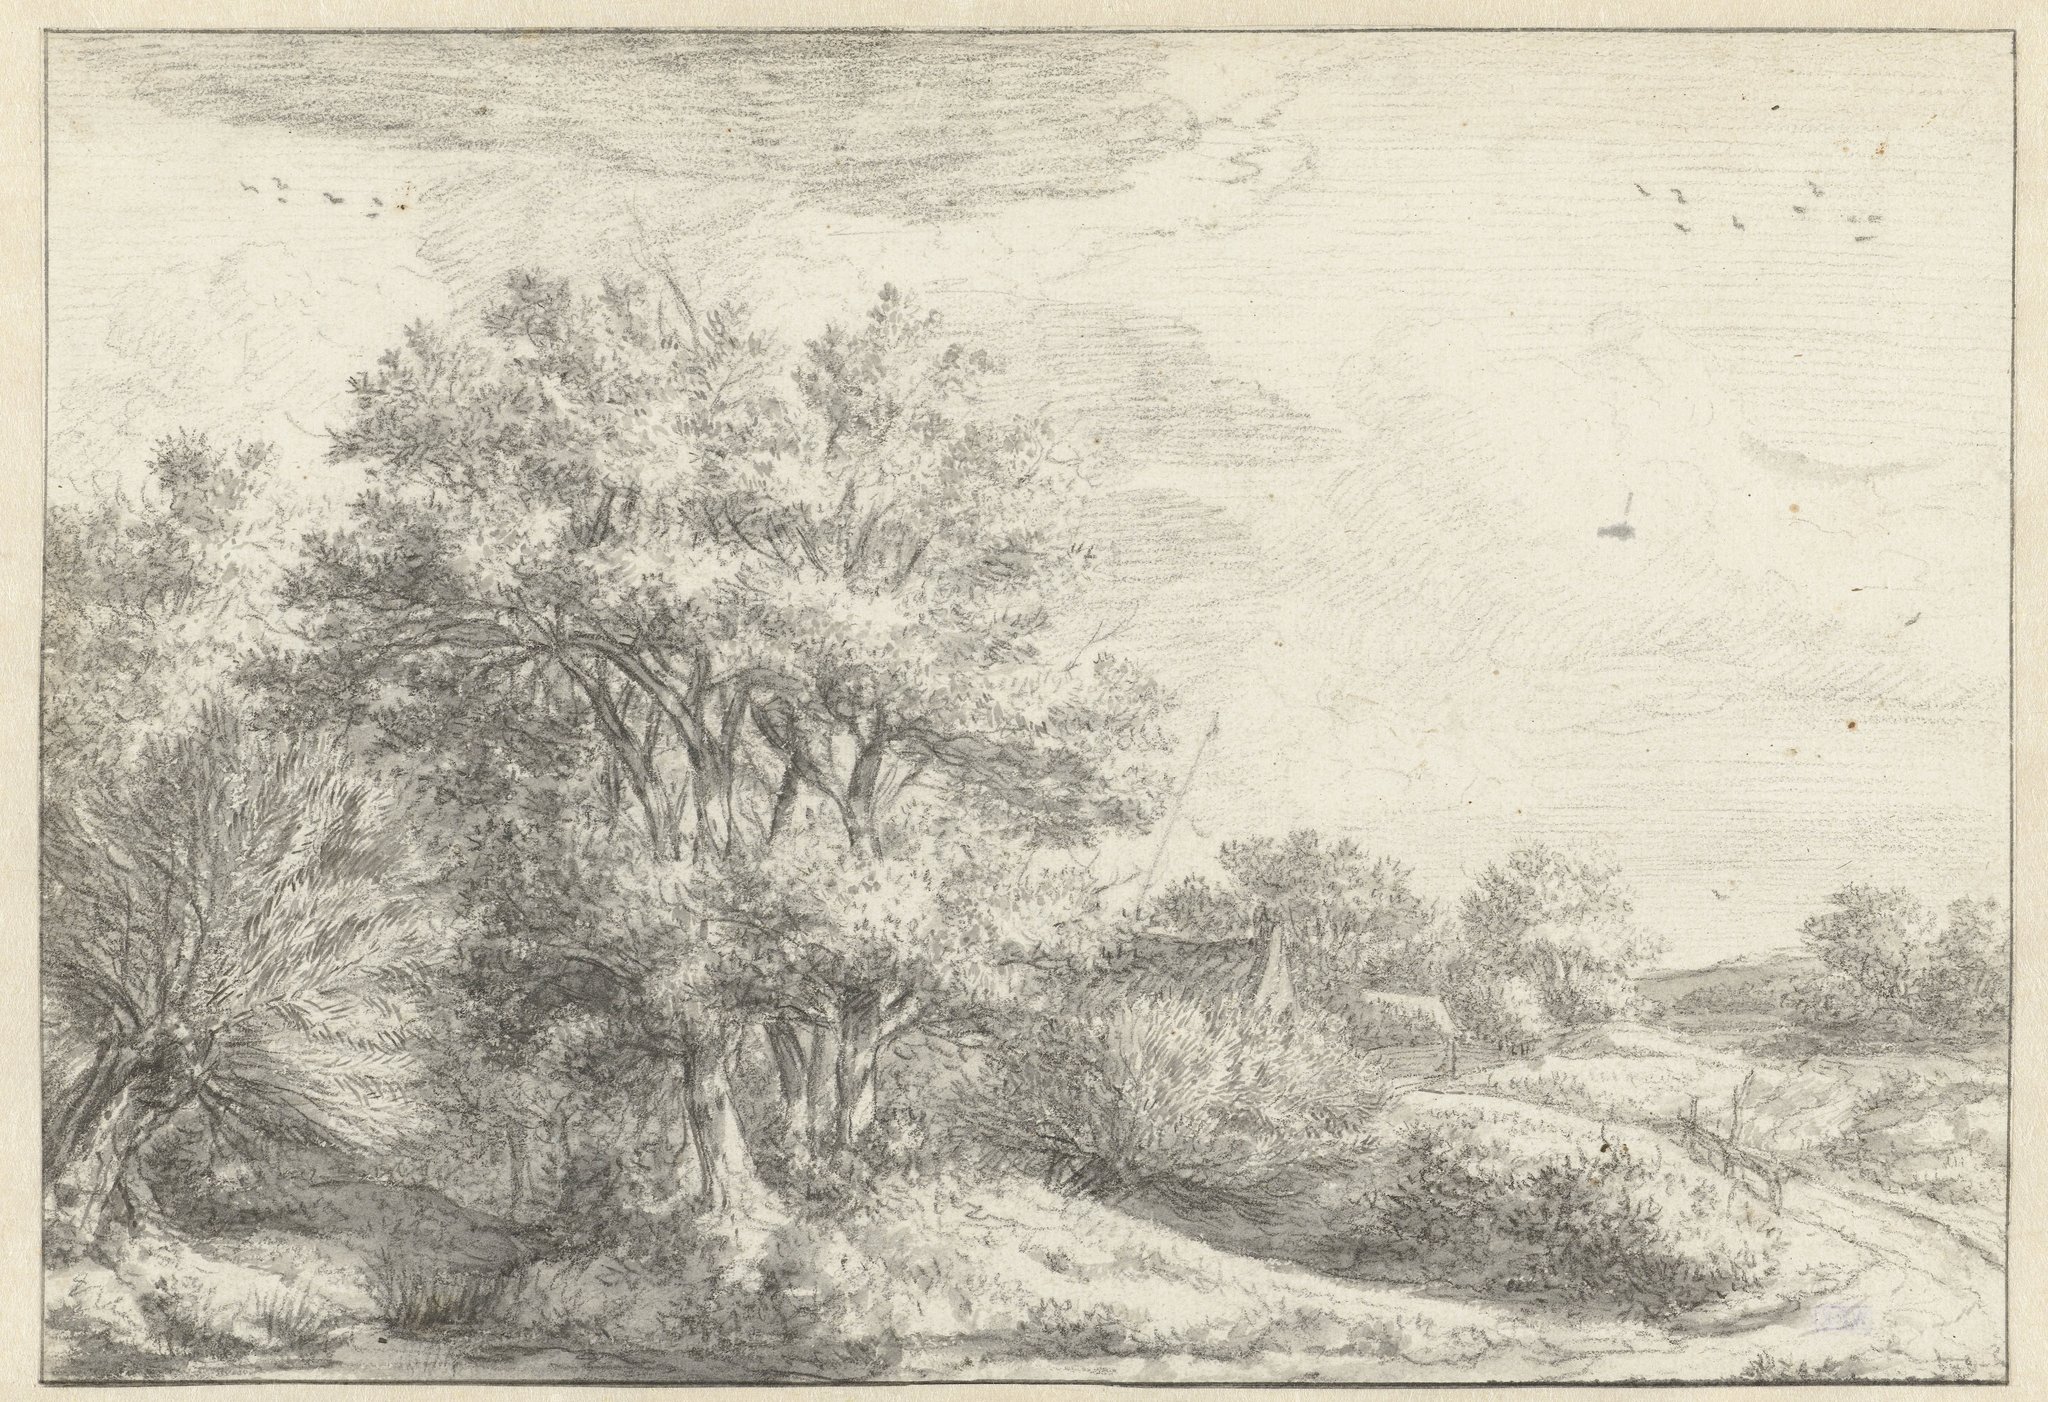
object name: drawing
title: Boomrijk landschap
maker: jacob isaacksz van ruisdael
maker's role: draughtsman, painter, print maker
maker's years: 1628-1682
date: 1638-1682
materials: chalk, paper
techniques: brush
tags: landscapes in the temperate zone